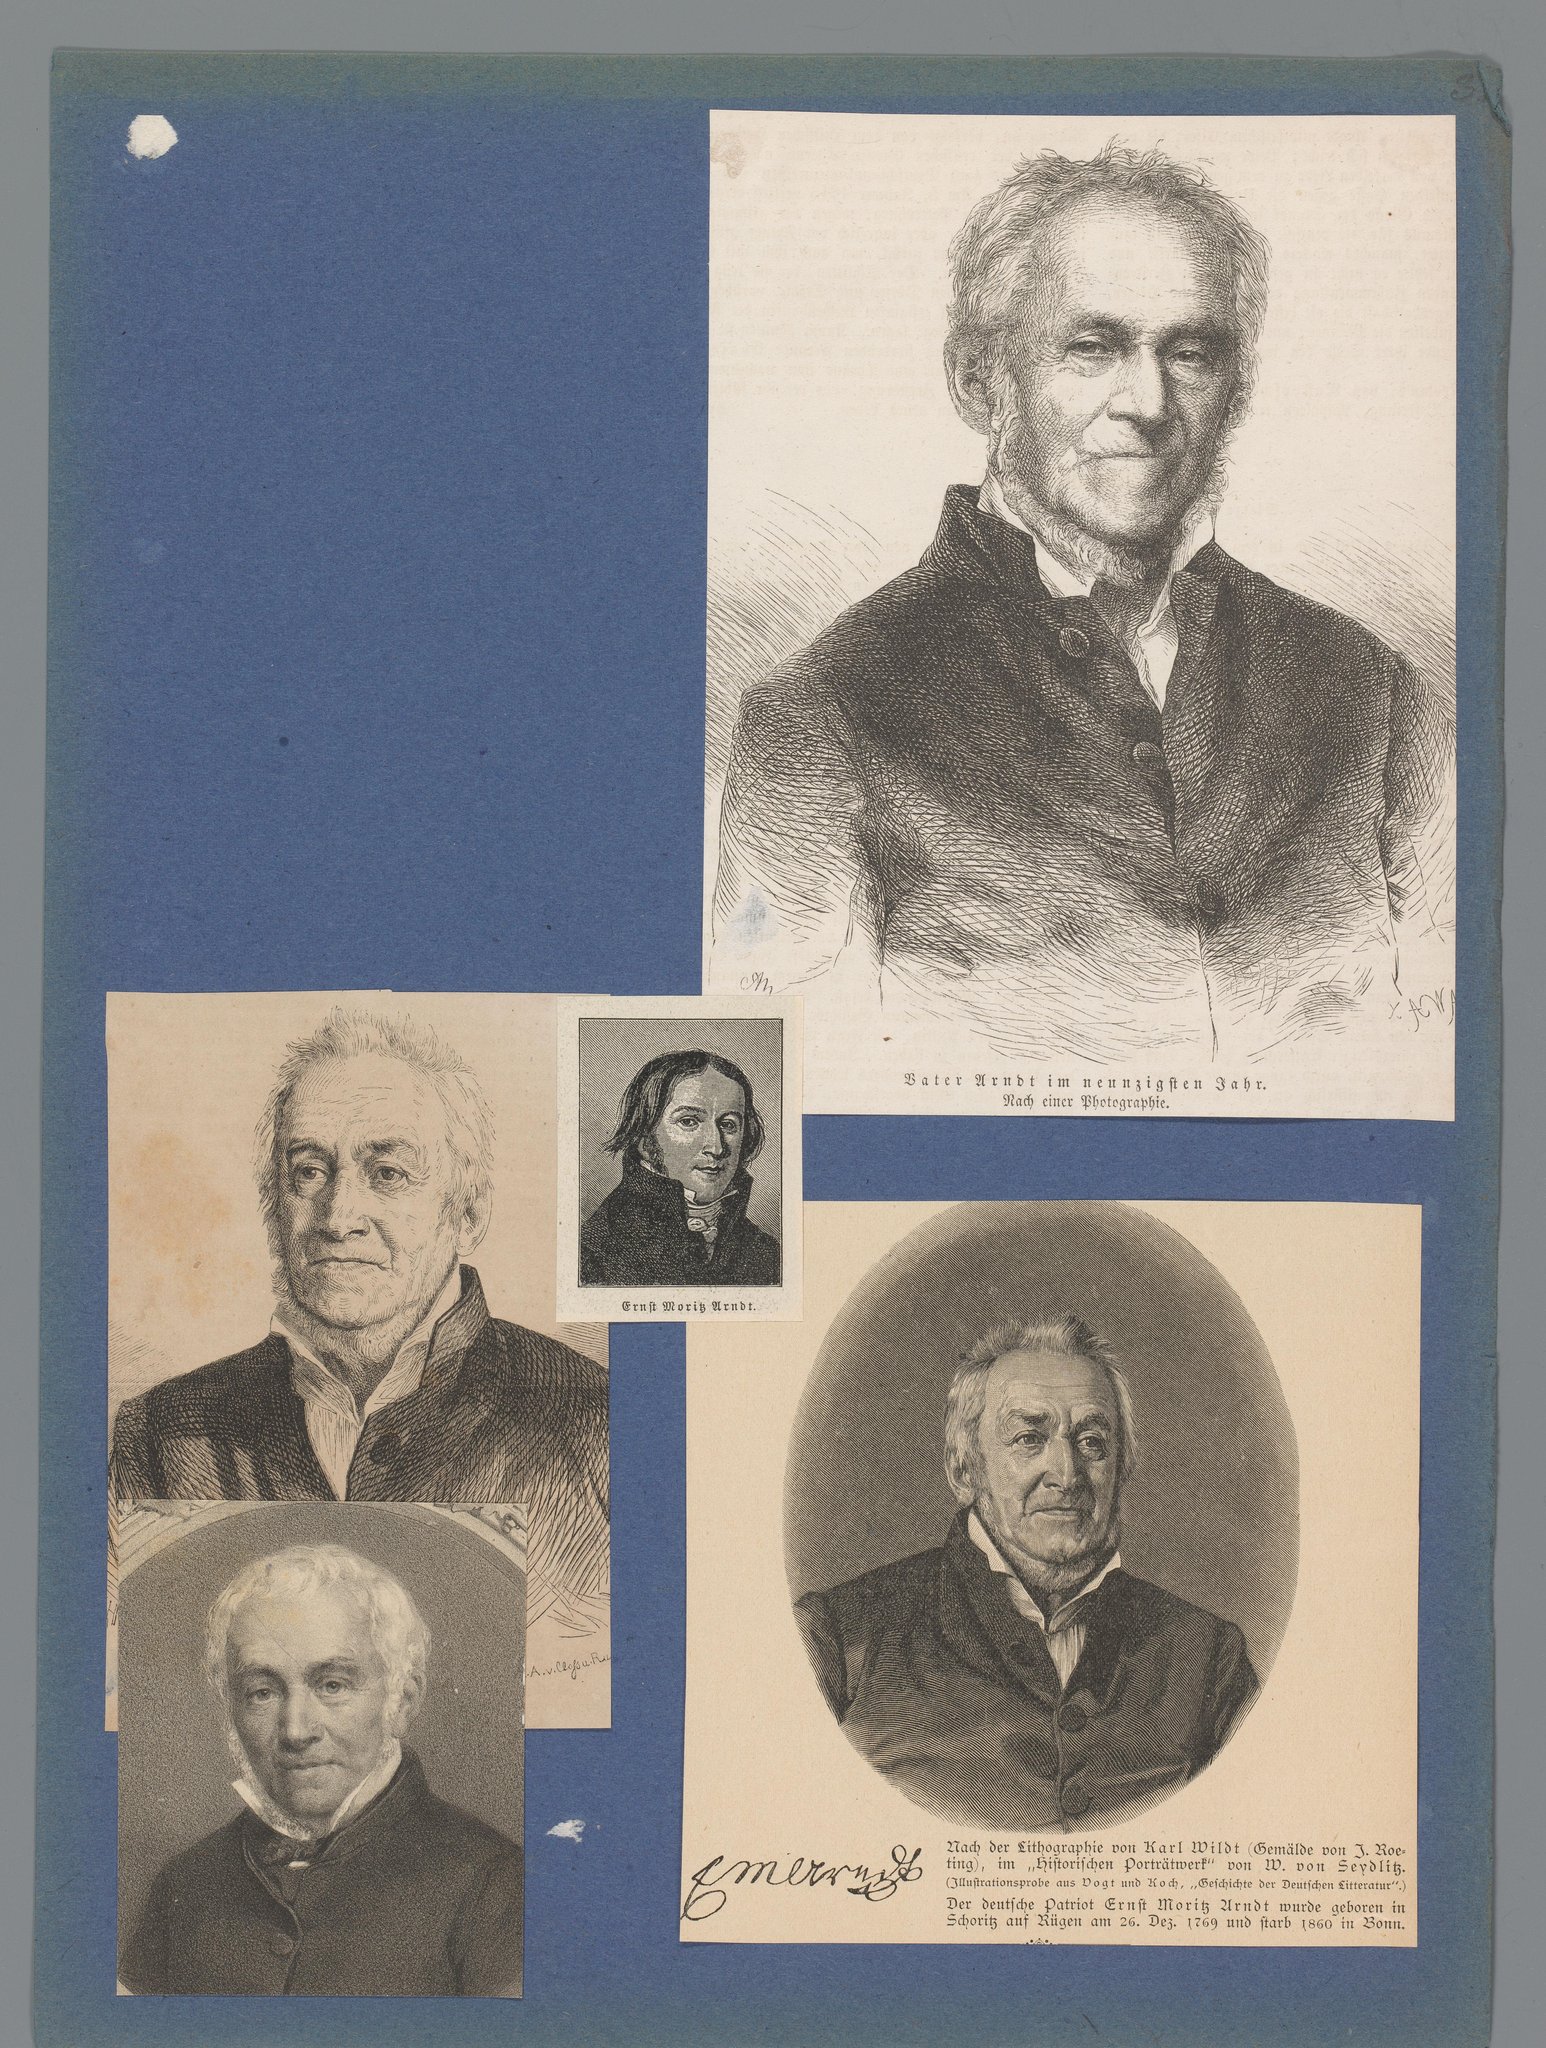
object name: sheet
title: Blad met vijf portretten van Ernst Moritz Arndt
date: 1850-1900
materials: paper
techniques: lithograph, snipping, engraving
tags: historical persons, portrait of a writer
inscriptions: signature: ‘[...]’, number: ‘3.’, signature: ‘A.v.Clofs u. Ru[...]’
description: Met facsimile handtekening van de geportretteerde.